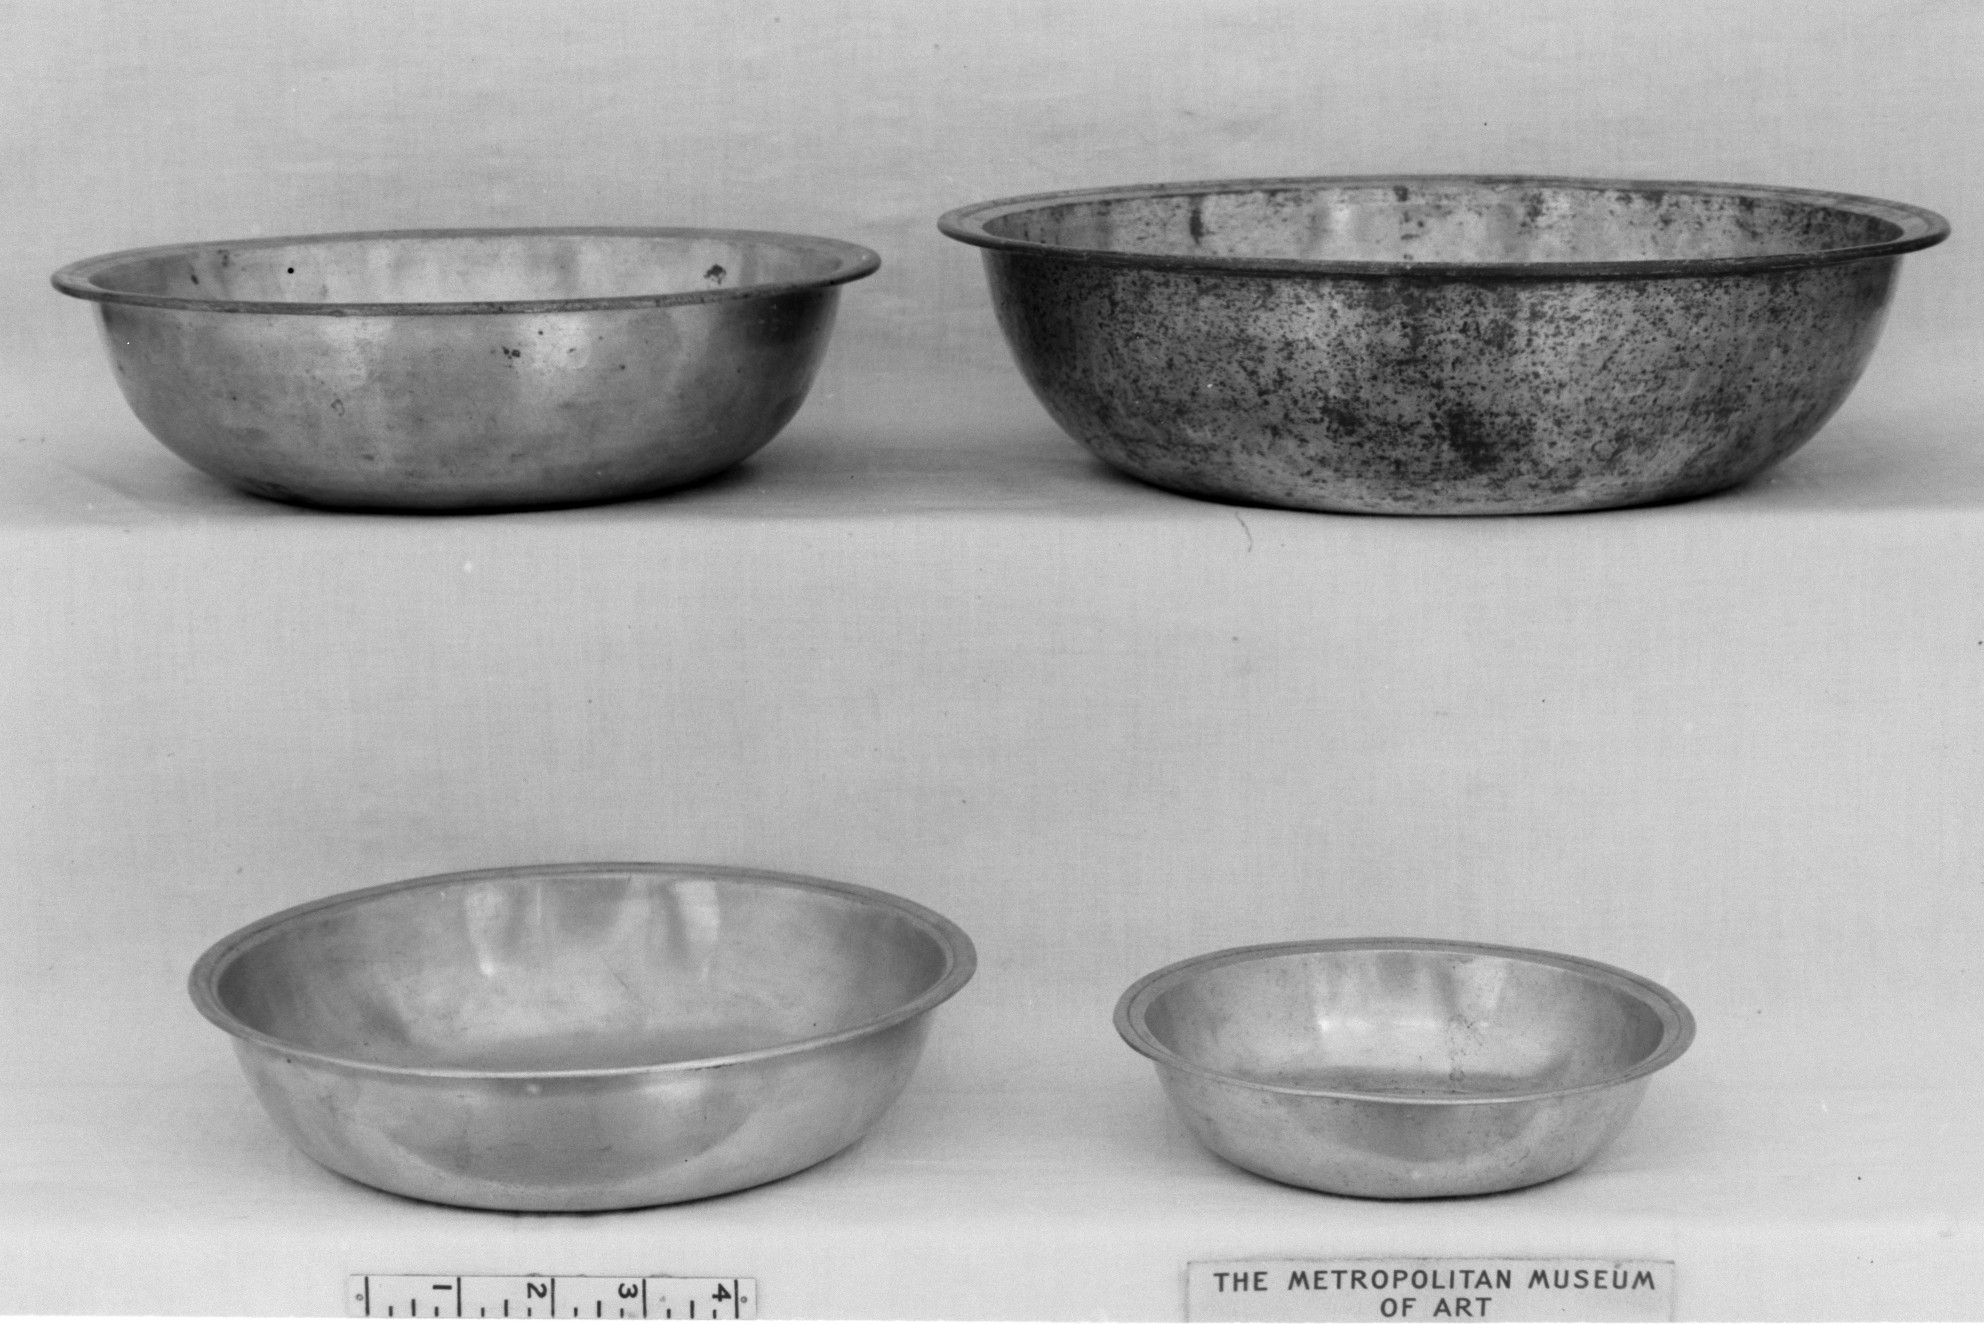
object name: bowl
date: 1701-1800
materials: pewter